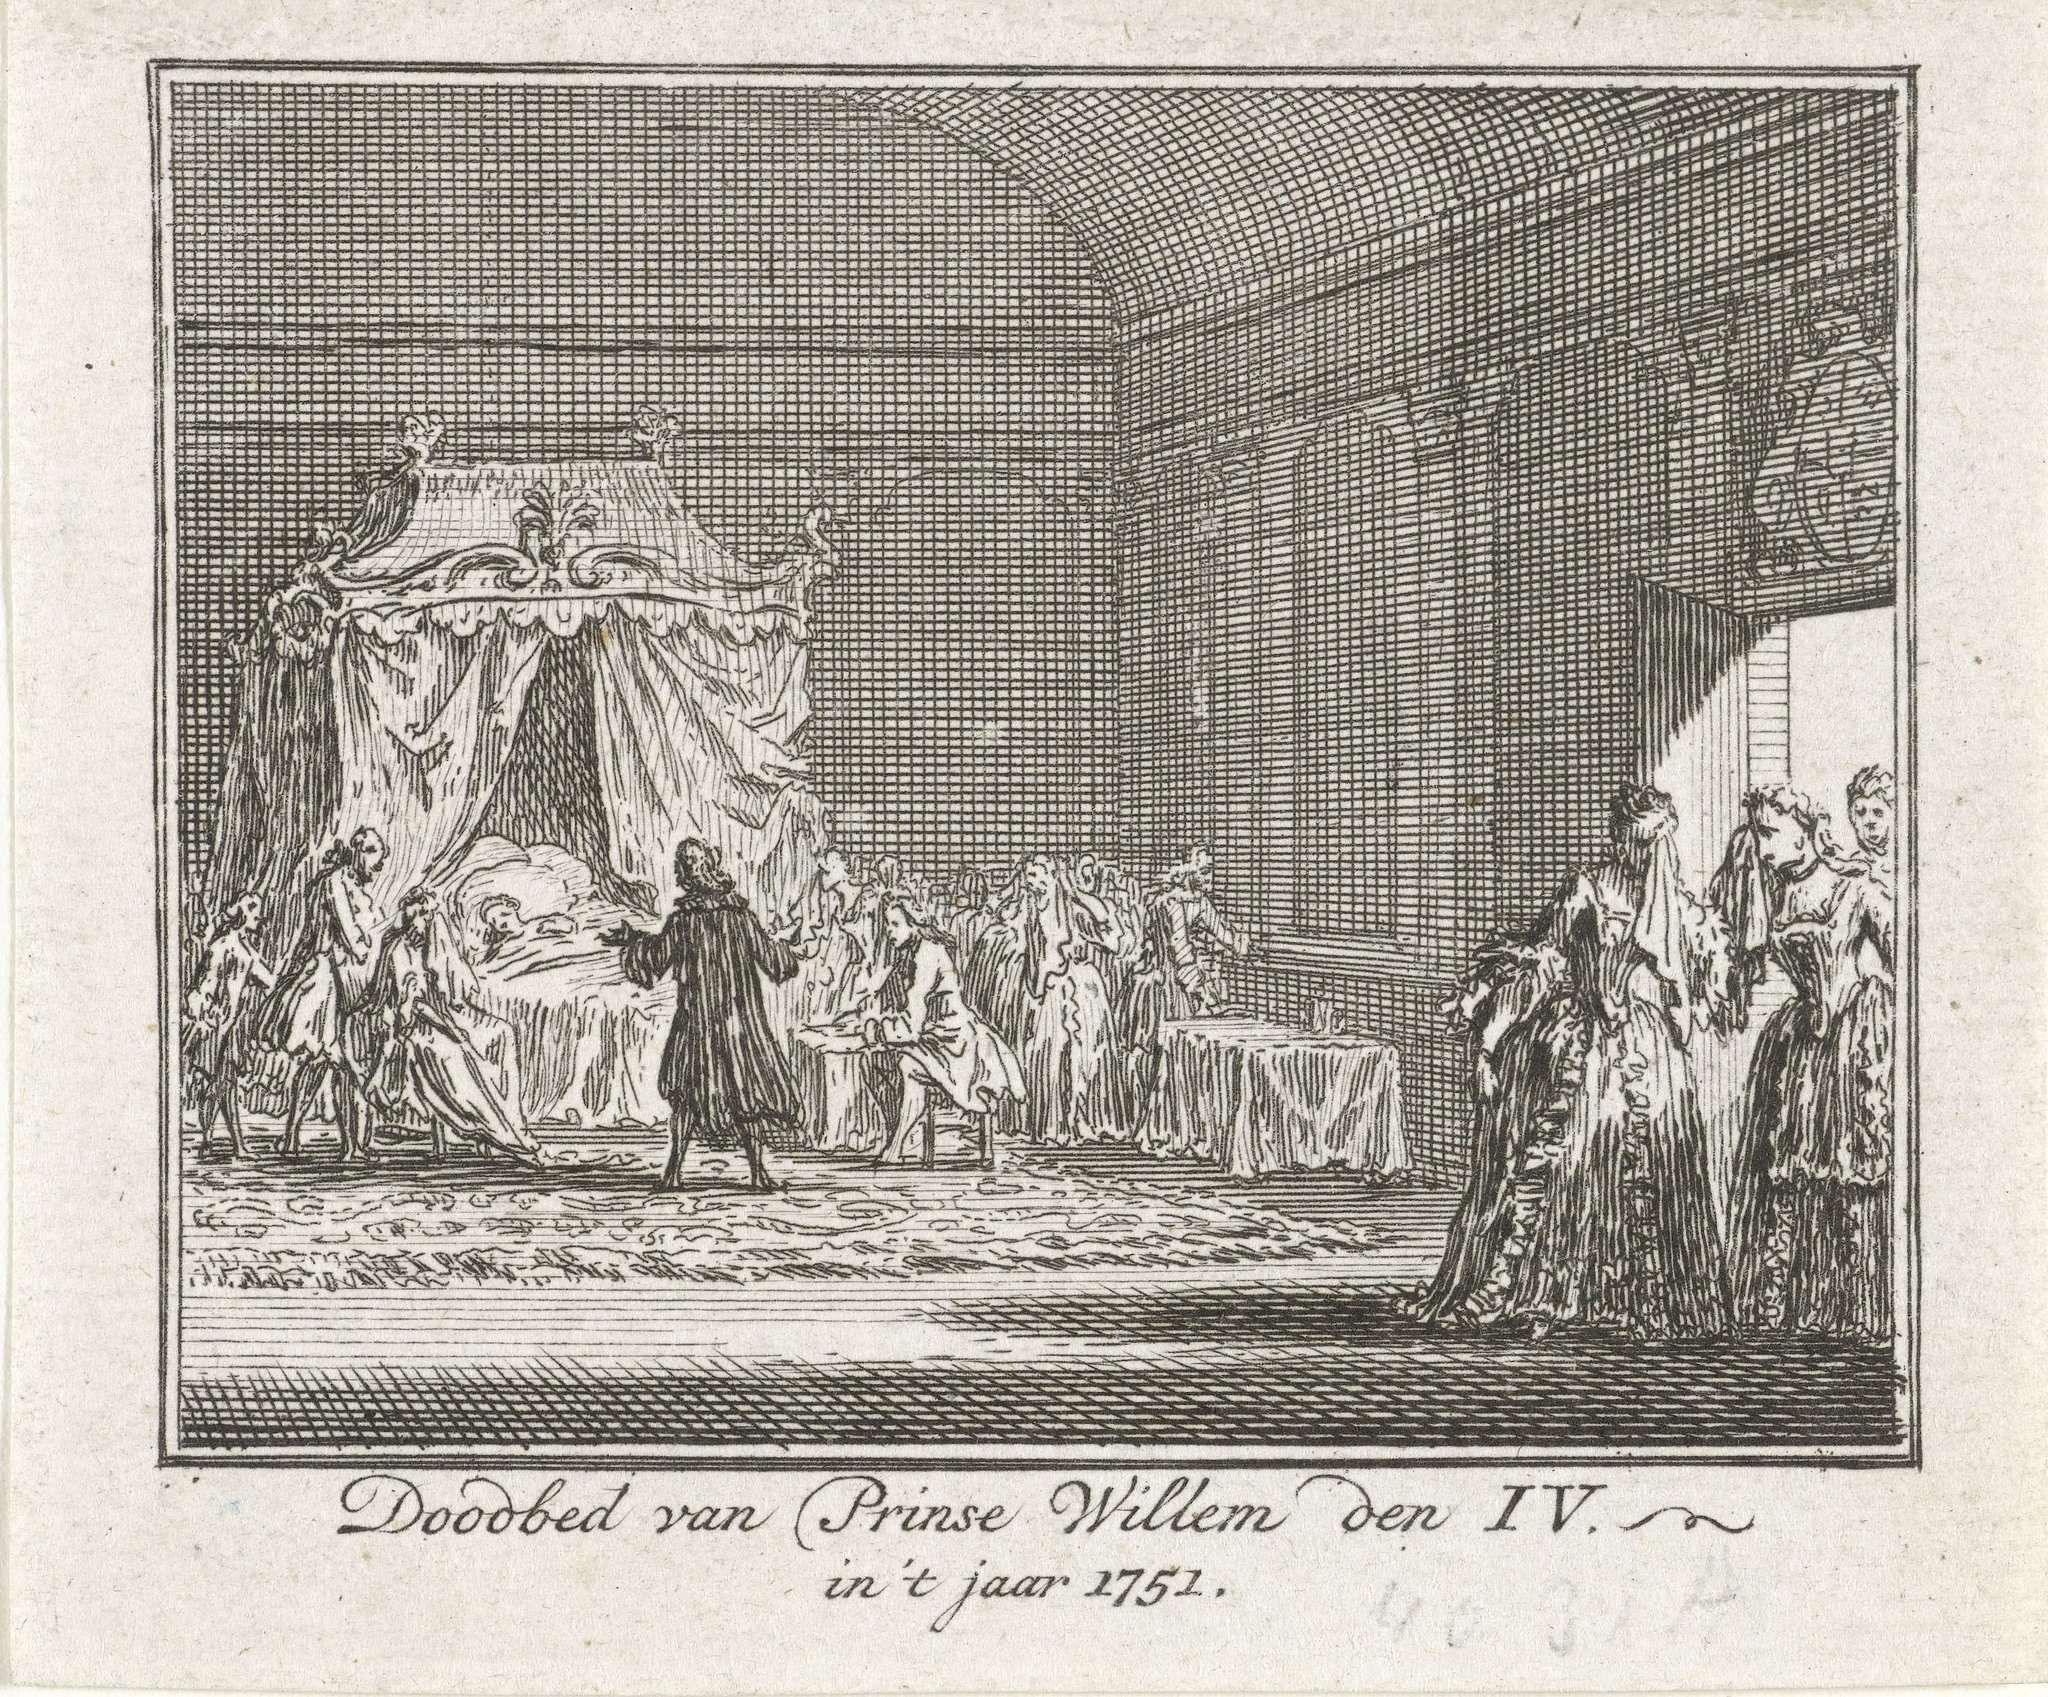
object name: print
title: Doodbed van Prinse Willem den IV. in 't jaar 1751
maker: simon fokke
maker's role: draughtsman, print maker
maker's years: 1712-1784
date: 1756-1758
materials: paper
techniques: engraving, etching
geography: northern netherlands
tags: the hague, willem iv (prins van oranje-nassau), deathbed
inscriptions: collector's mark: Lugt 2228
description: Dit nummer is een door het RPK toegevoegd nummer en staat niet in Frederik Muller, het werk waar de prent voor is gemaakt of uit afkomstig is, staat wel vermeld in Frederik Muller. Gebruikt als illustratie in: Jan Wagenaar en Simon Fokke, Vaderlandsche historie verkort, en by vraagen en antwoorden voorgesteld, Isaak Tirion, Amsterdam 1758.